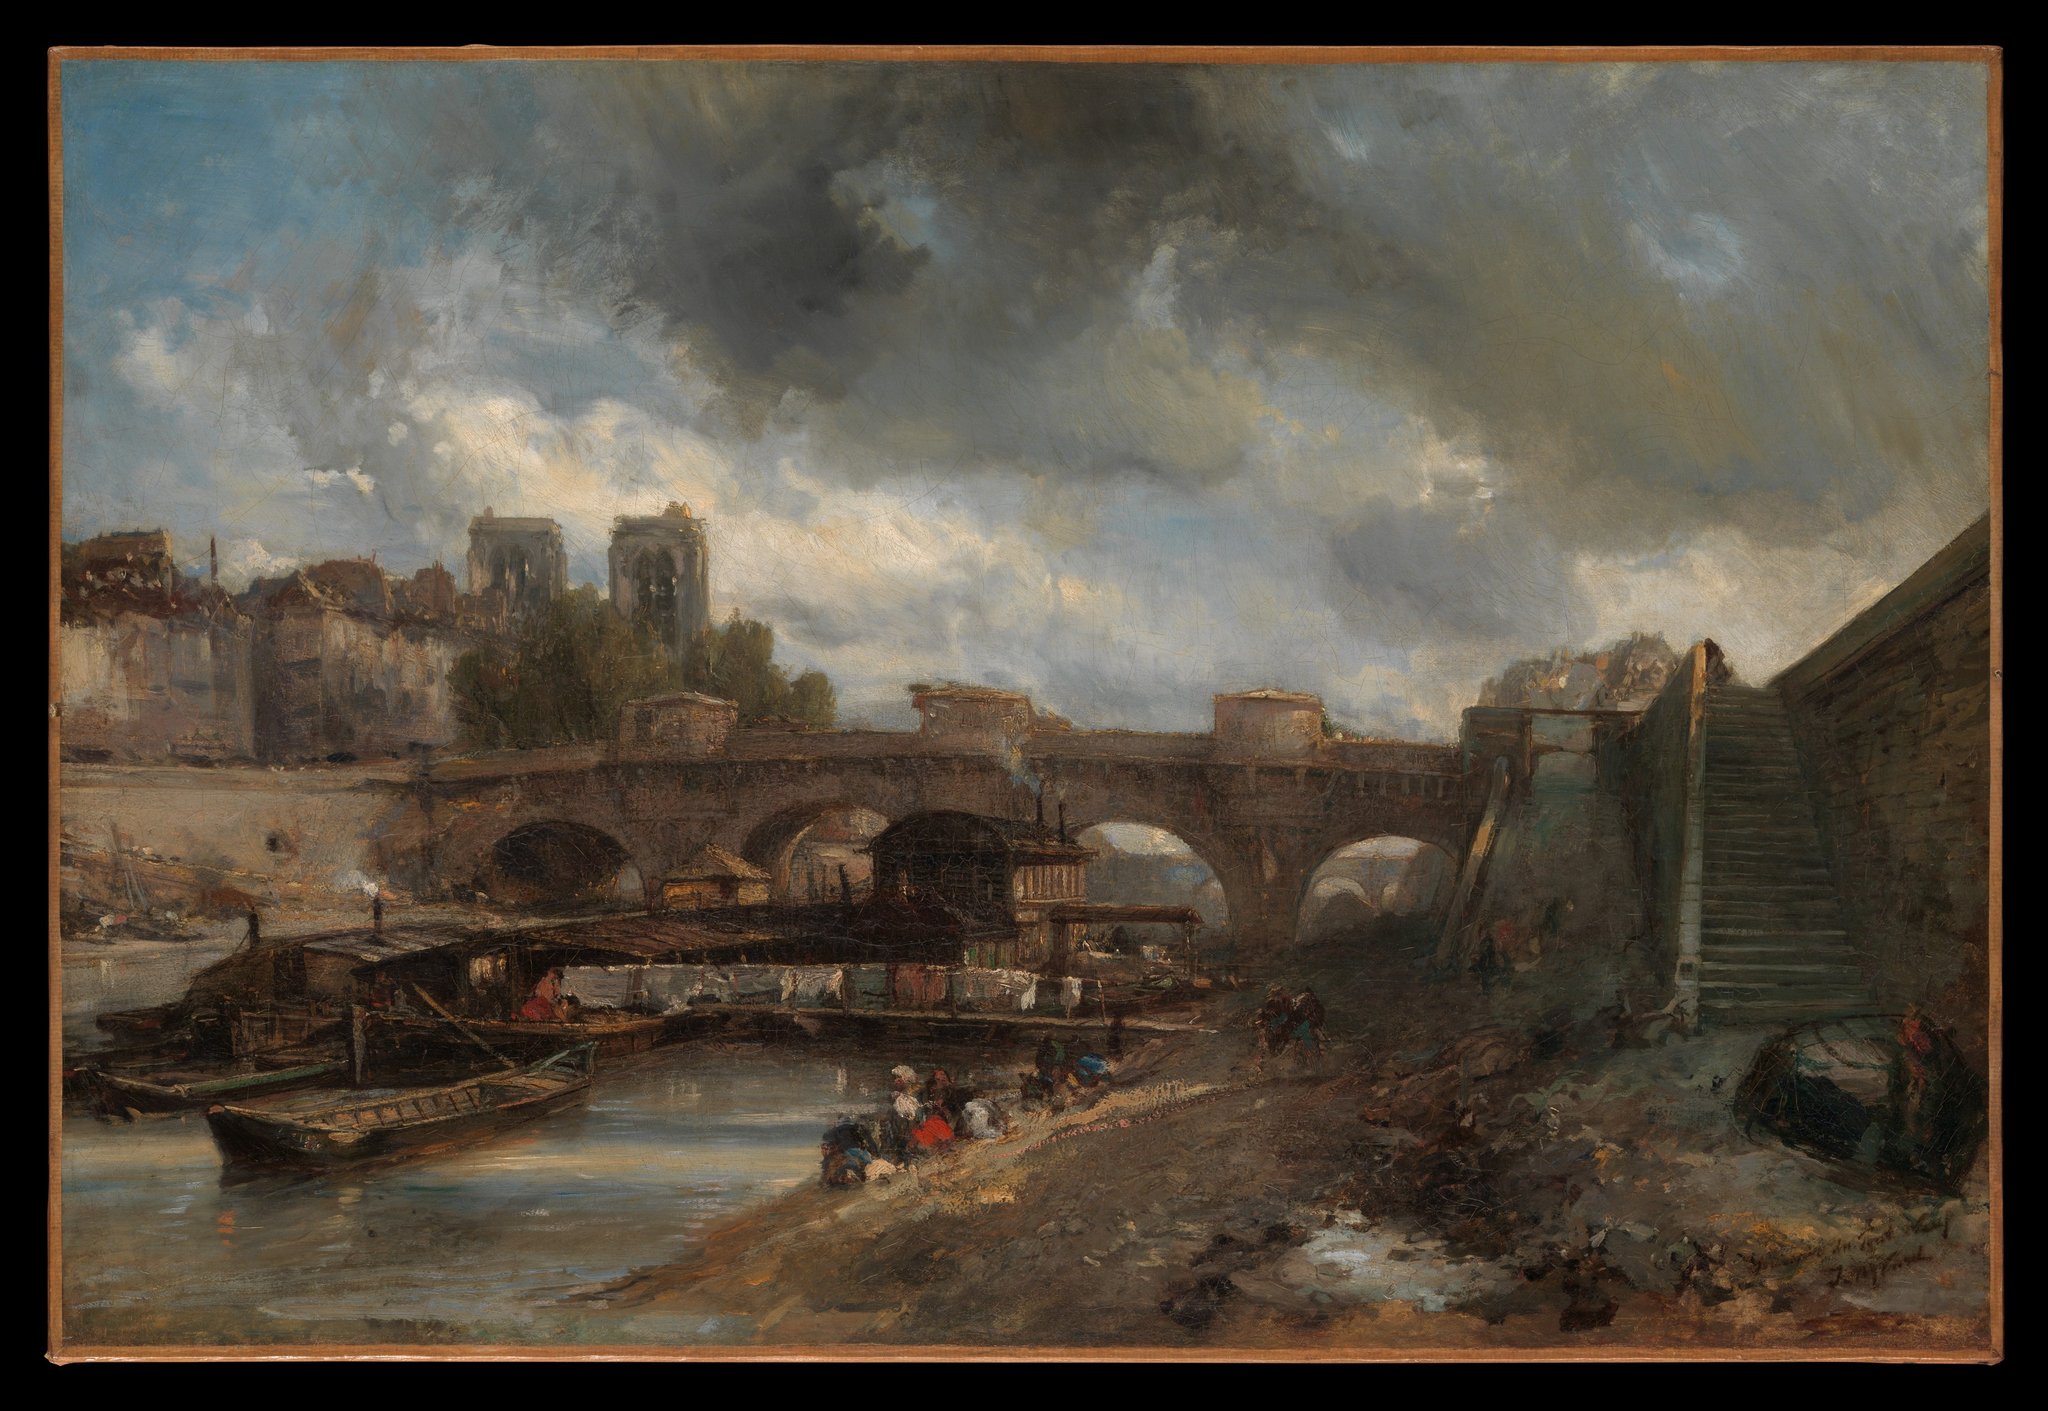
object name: painting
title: The Pont Neuf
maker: johan barthold jongkind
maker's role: artist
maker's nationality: dutch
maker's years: 1819-1891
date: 1849-1850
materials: canvas, oil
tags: bridges,rivers,boats,paris